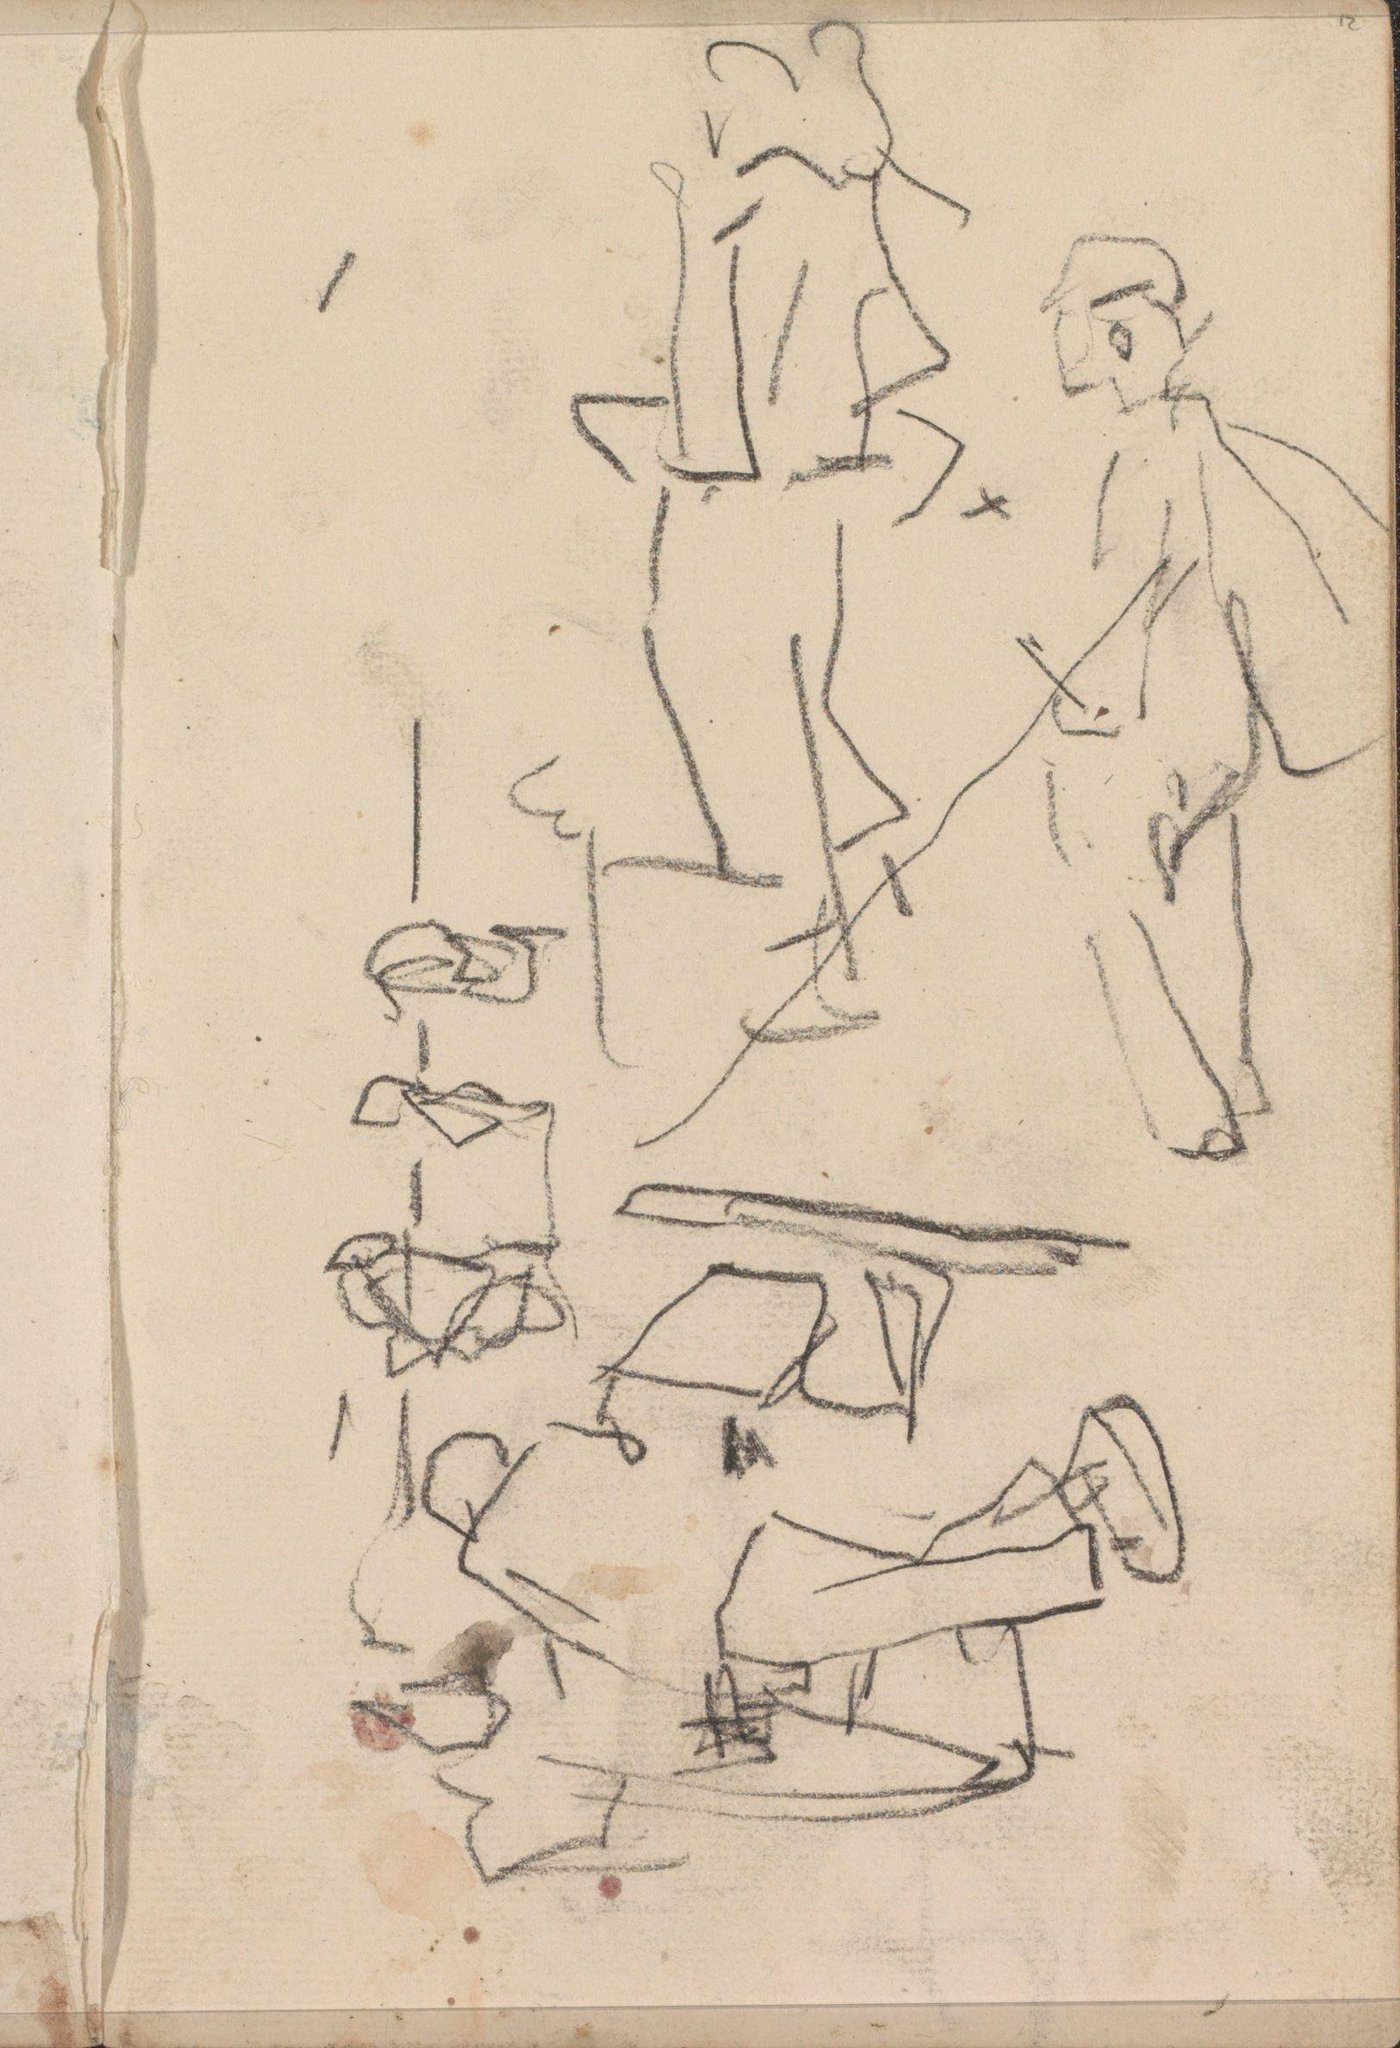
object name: sketchbook leaf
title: Figuurstudies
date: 1881-1883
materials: chalk, paper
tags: hand-cart, adult man, carrying something on the head or on the shoulders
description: Mannen met bagage op hun rug en mannen achter handkarren. Pagina 12 uit een schetsboek met 19 bladen.